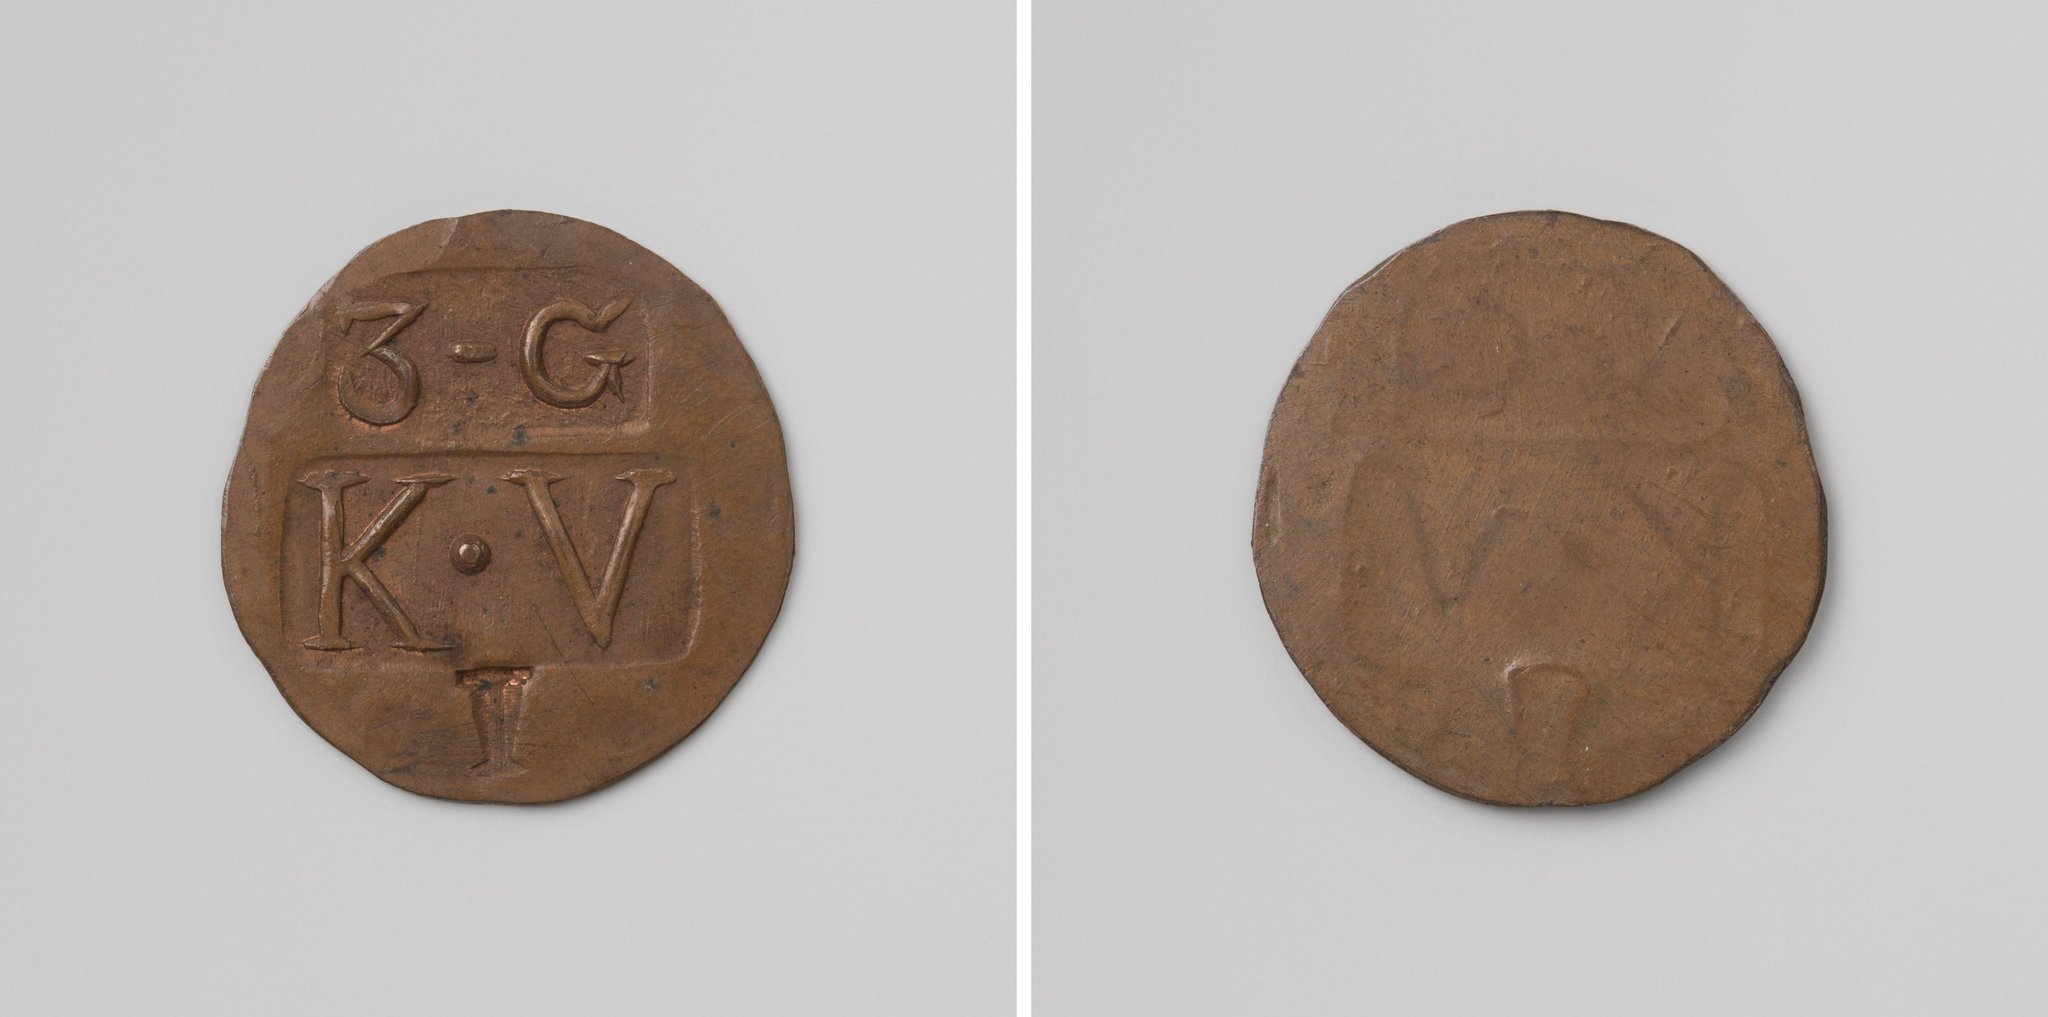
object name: cent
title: Derde gesticht van de kolonie Veenhuizen, huismunt geslagen op last van de Maatschappij van Weldadigheid ter waarde van een cent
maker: Anonymous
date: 1818-1859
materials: copper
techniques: striking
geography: netherlands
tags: maatschappij van weldadigheid, veenhuizen